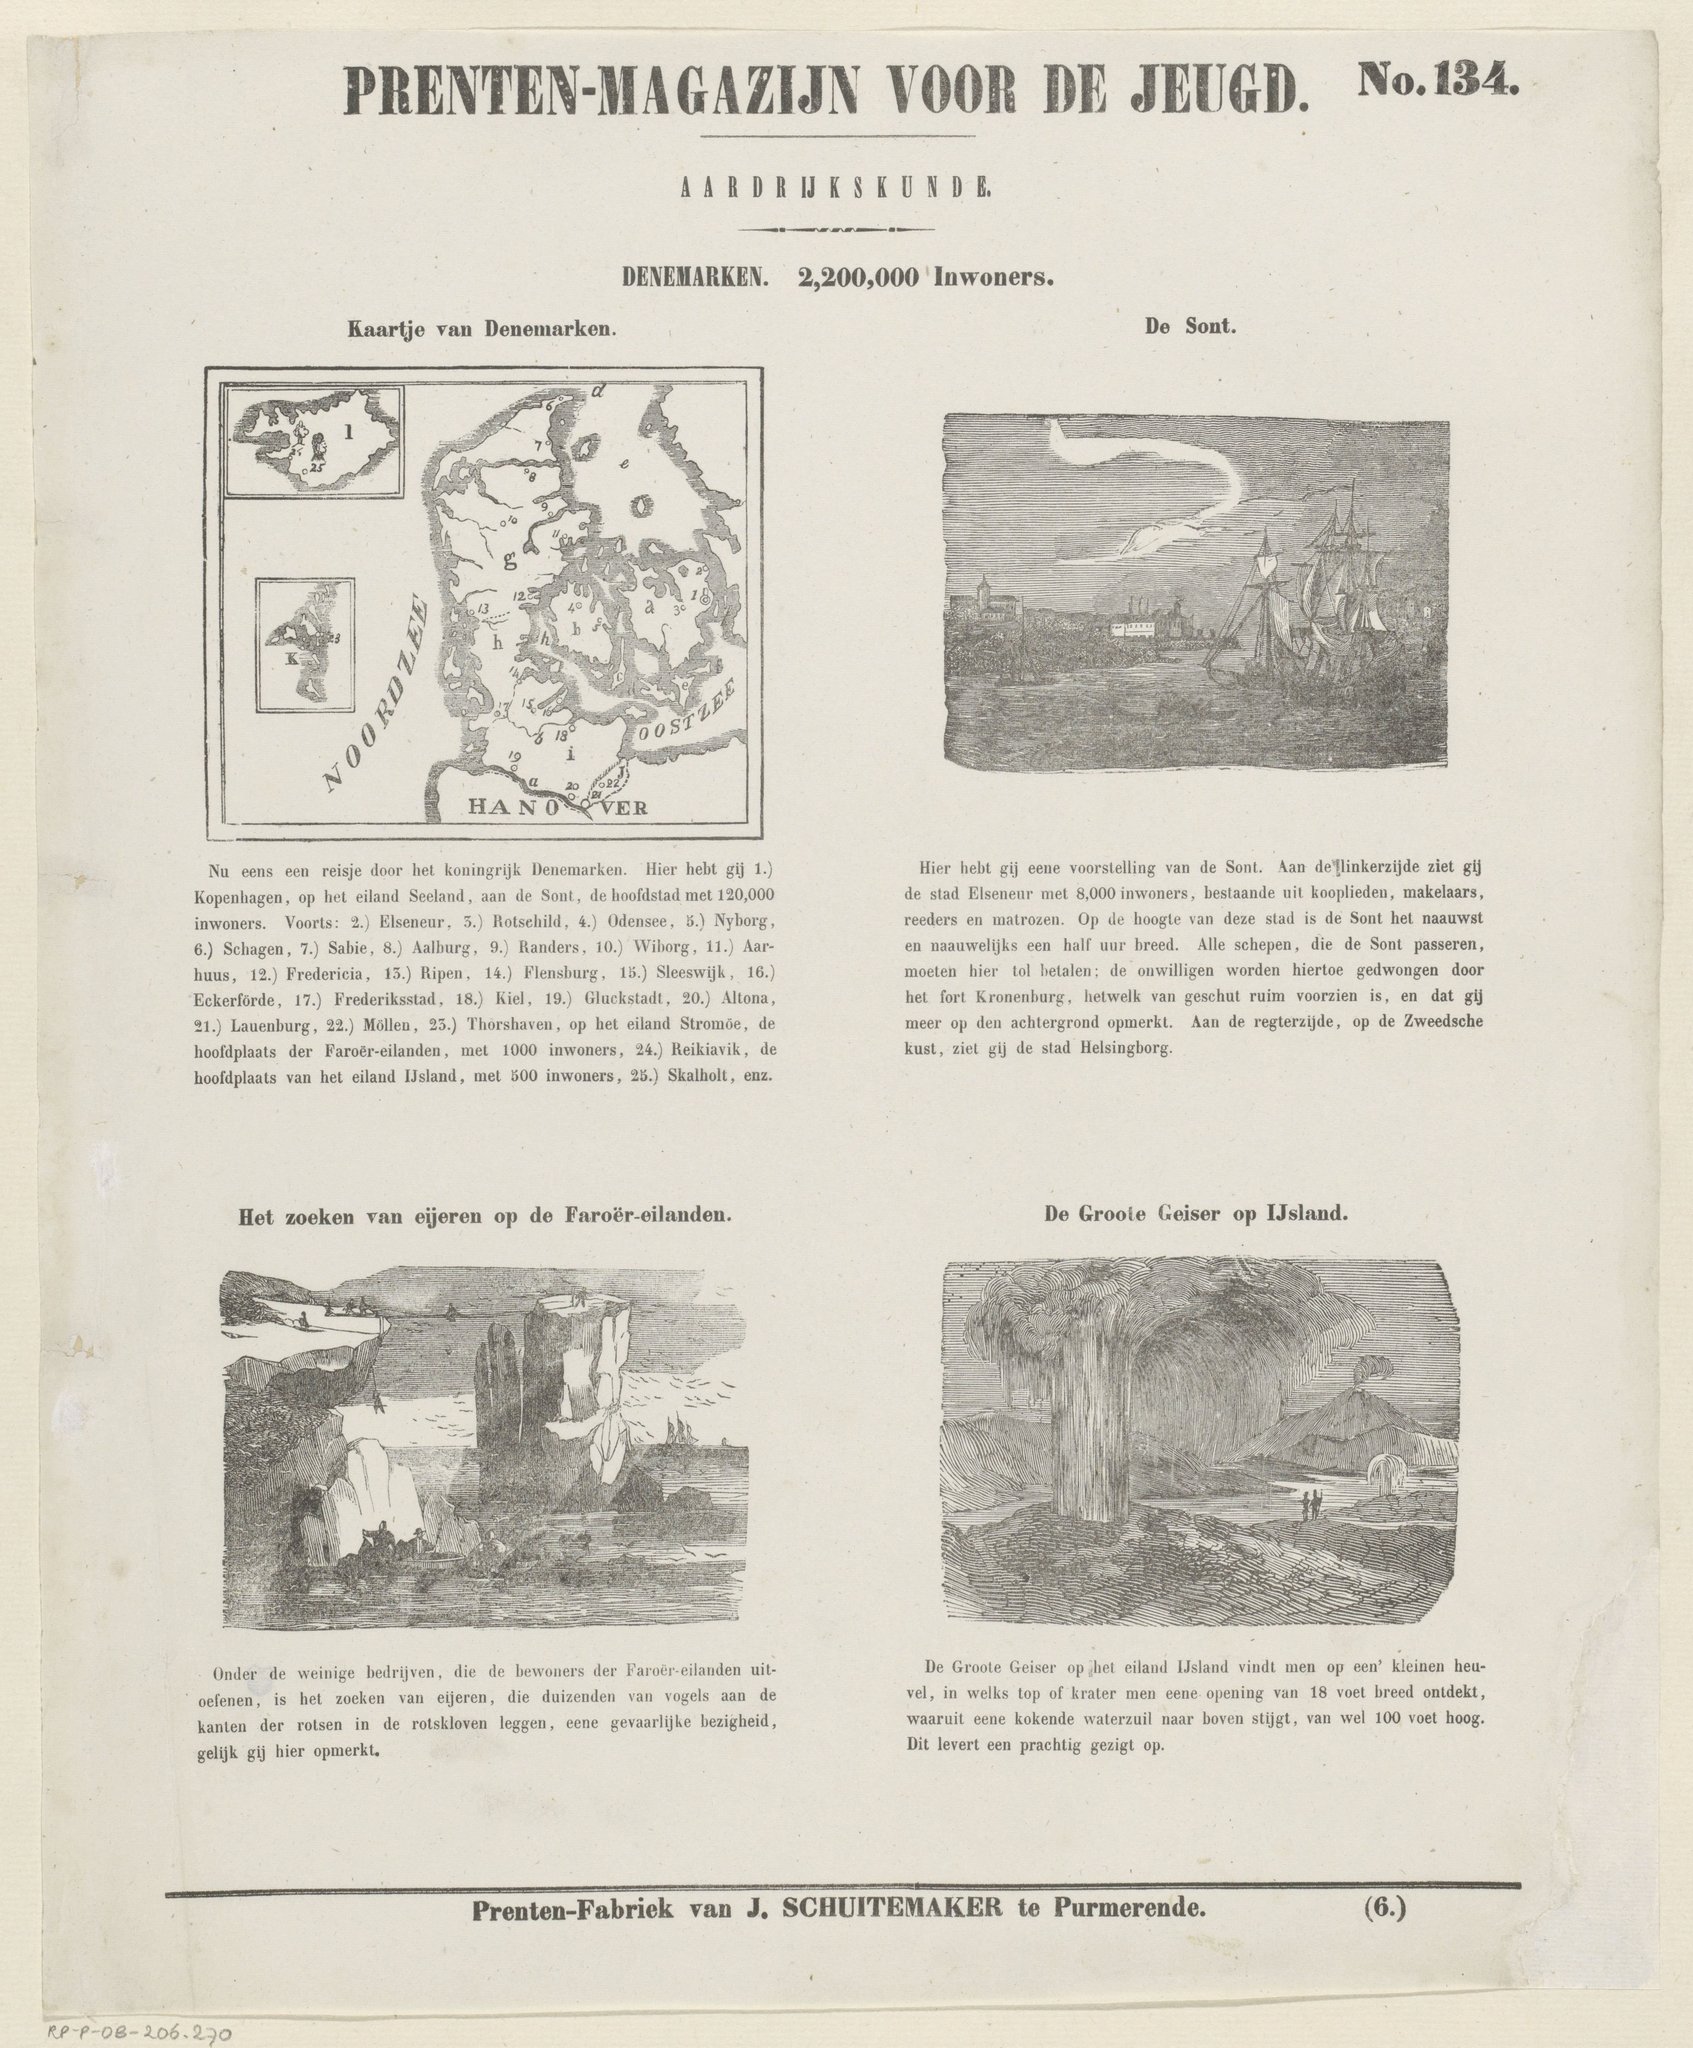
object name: popular print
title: Aardrijkskunde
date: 1850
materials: paper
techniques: letterpress printing, engraving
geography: purmerend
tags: hot spring, geyser, maps, atlases, denmark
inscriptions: collector's mark: Lugt 2760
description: Na voltooiing van de acht jaargangen van de reeks 'Prenten-magazijn voor de jeugd' in 1850 heeft Jan Schuitemaker al deze prenten heruitgegeven en omgenummerd als nr. 1 t/m 192. De oorspronkelijke jaargang wordt telkens nog vermeld rechtsonder op de prent. Binnen de jaargangen zijn prenten van hetzelfde thema in clusters van vier achter elkaar gezet.